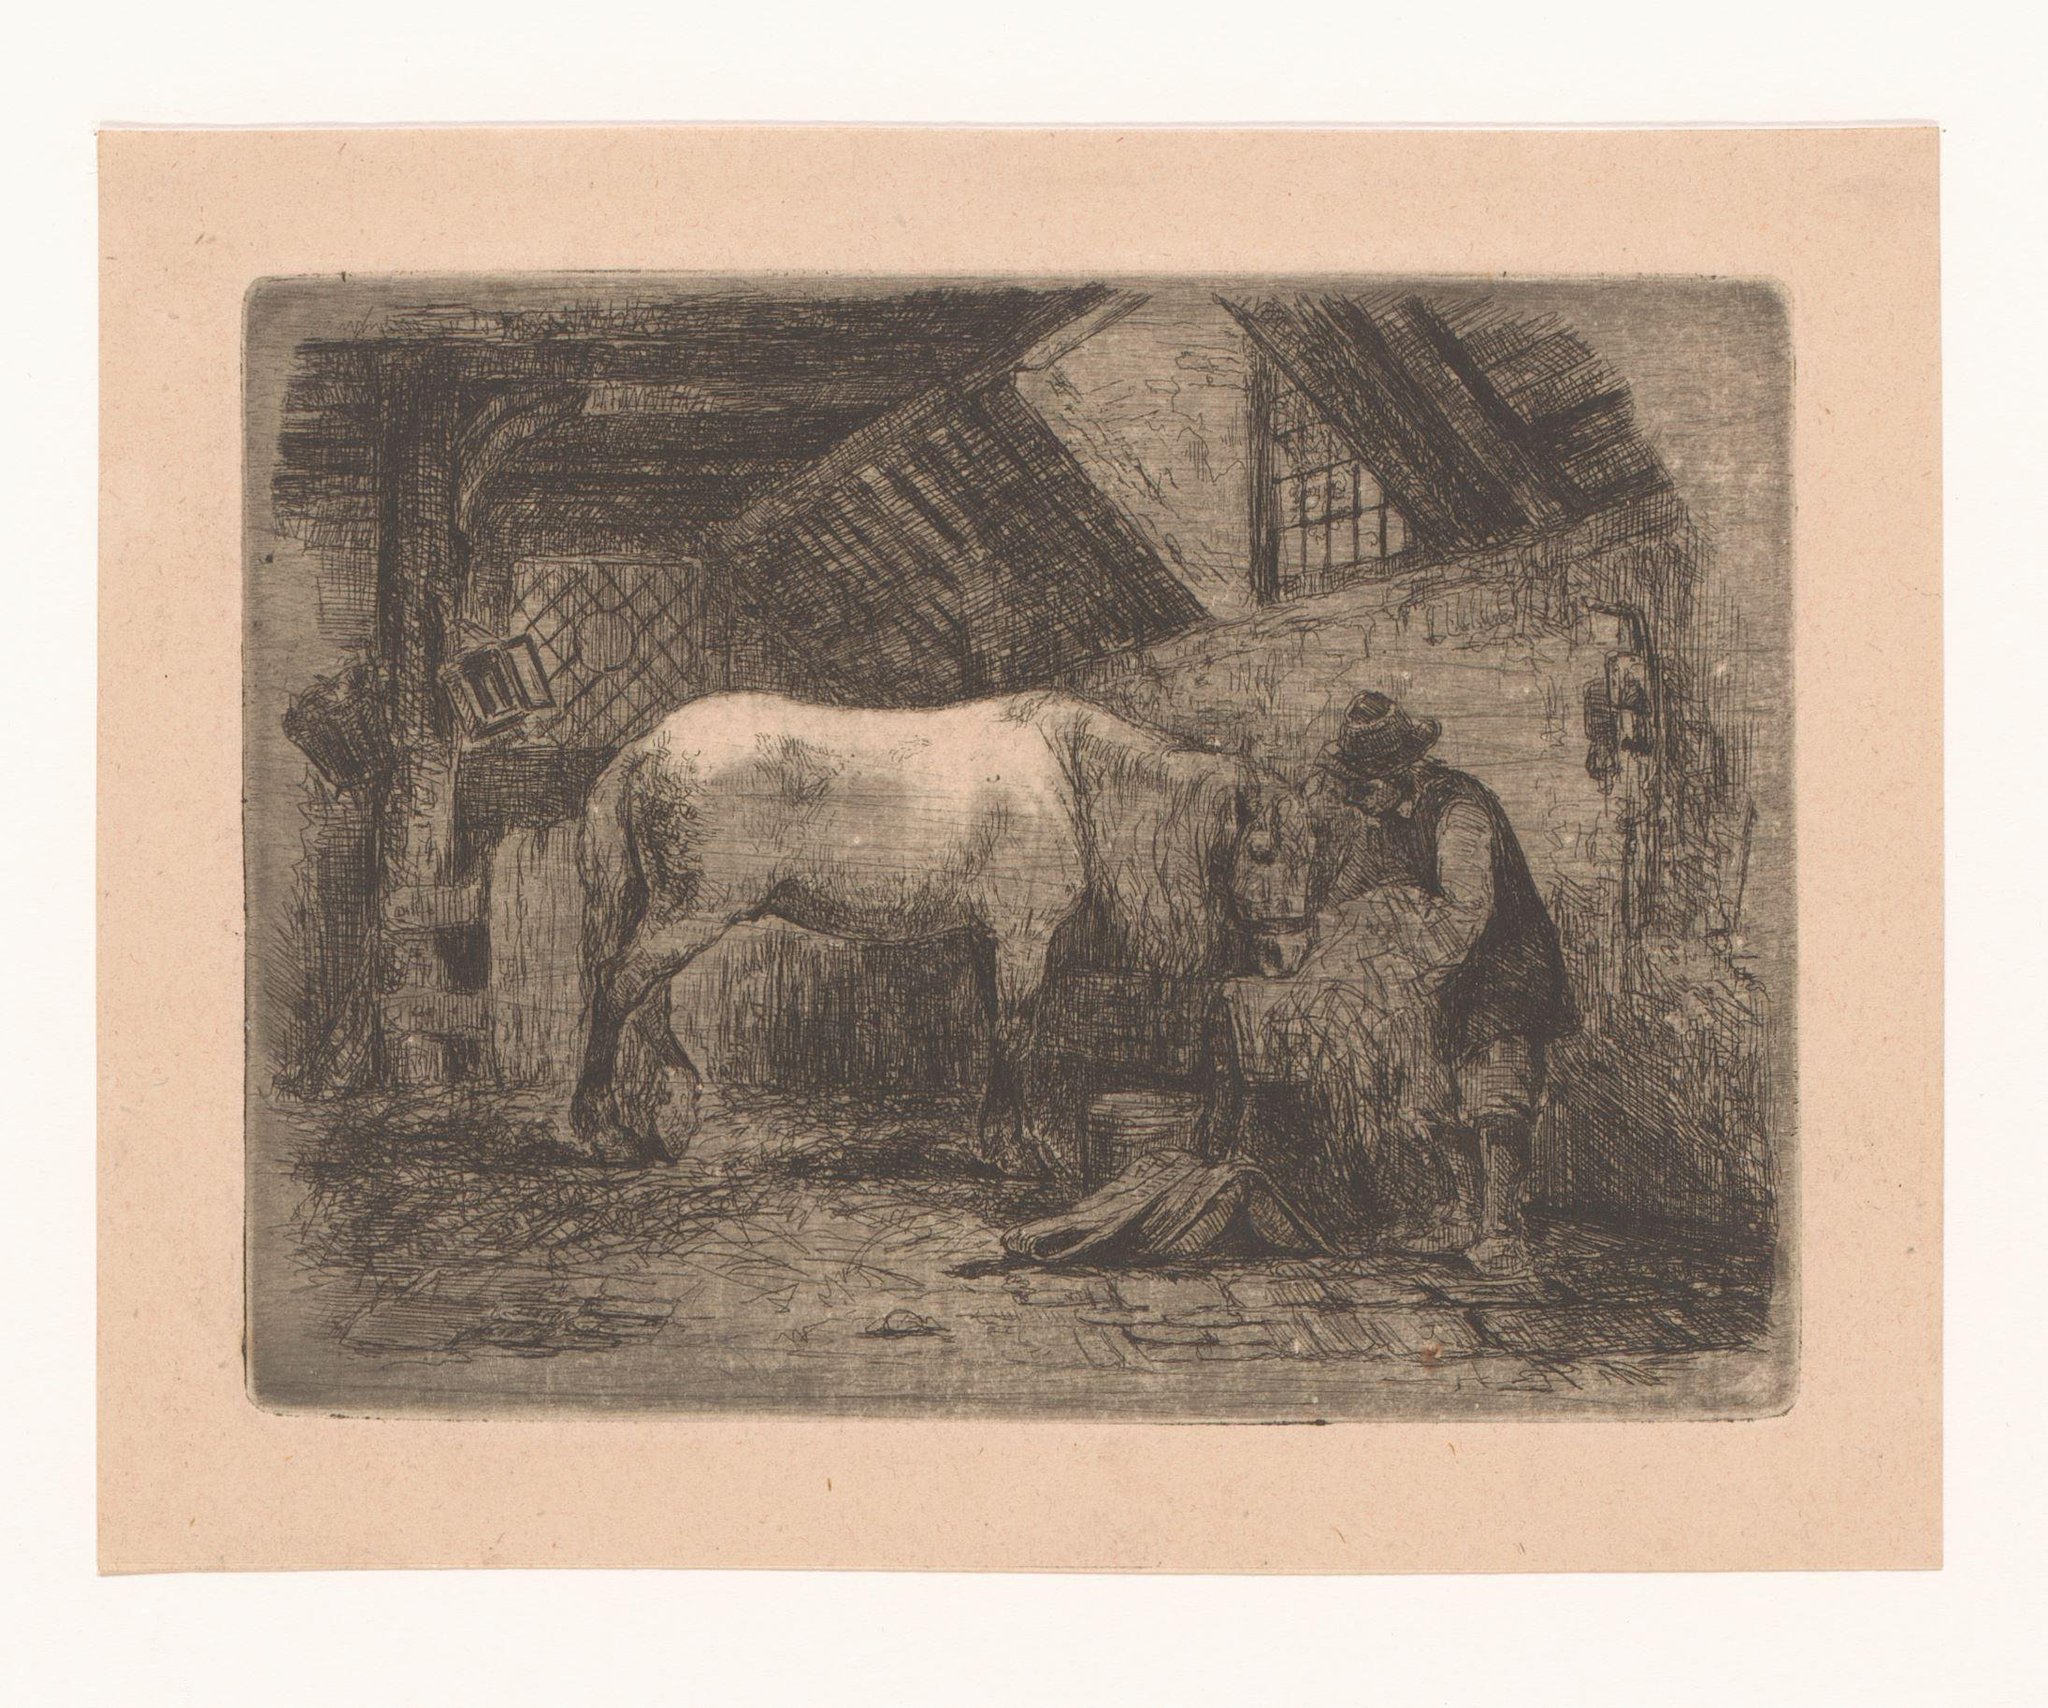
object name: print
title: Paard in een stal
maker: adrien joseph verhoeven-ball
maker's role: draughtsman, print maker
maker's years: 1824-1882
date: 1834-1882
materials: paper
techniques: drypoint, etching, intaglio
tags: horse, stall, stable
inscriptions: collector's mark: Lugt 1485, collector's mark: Lugt 2228